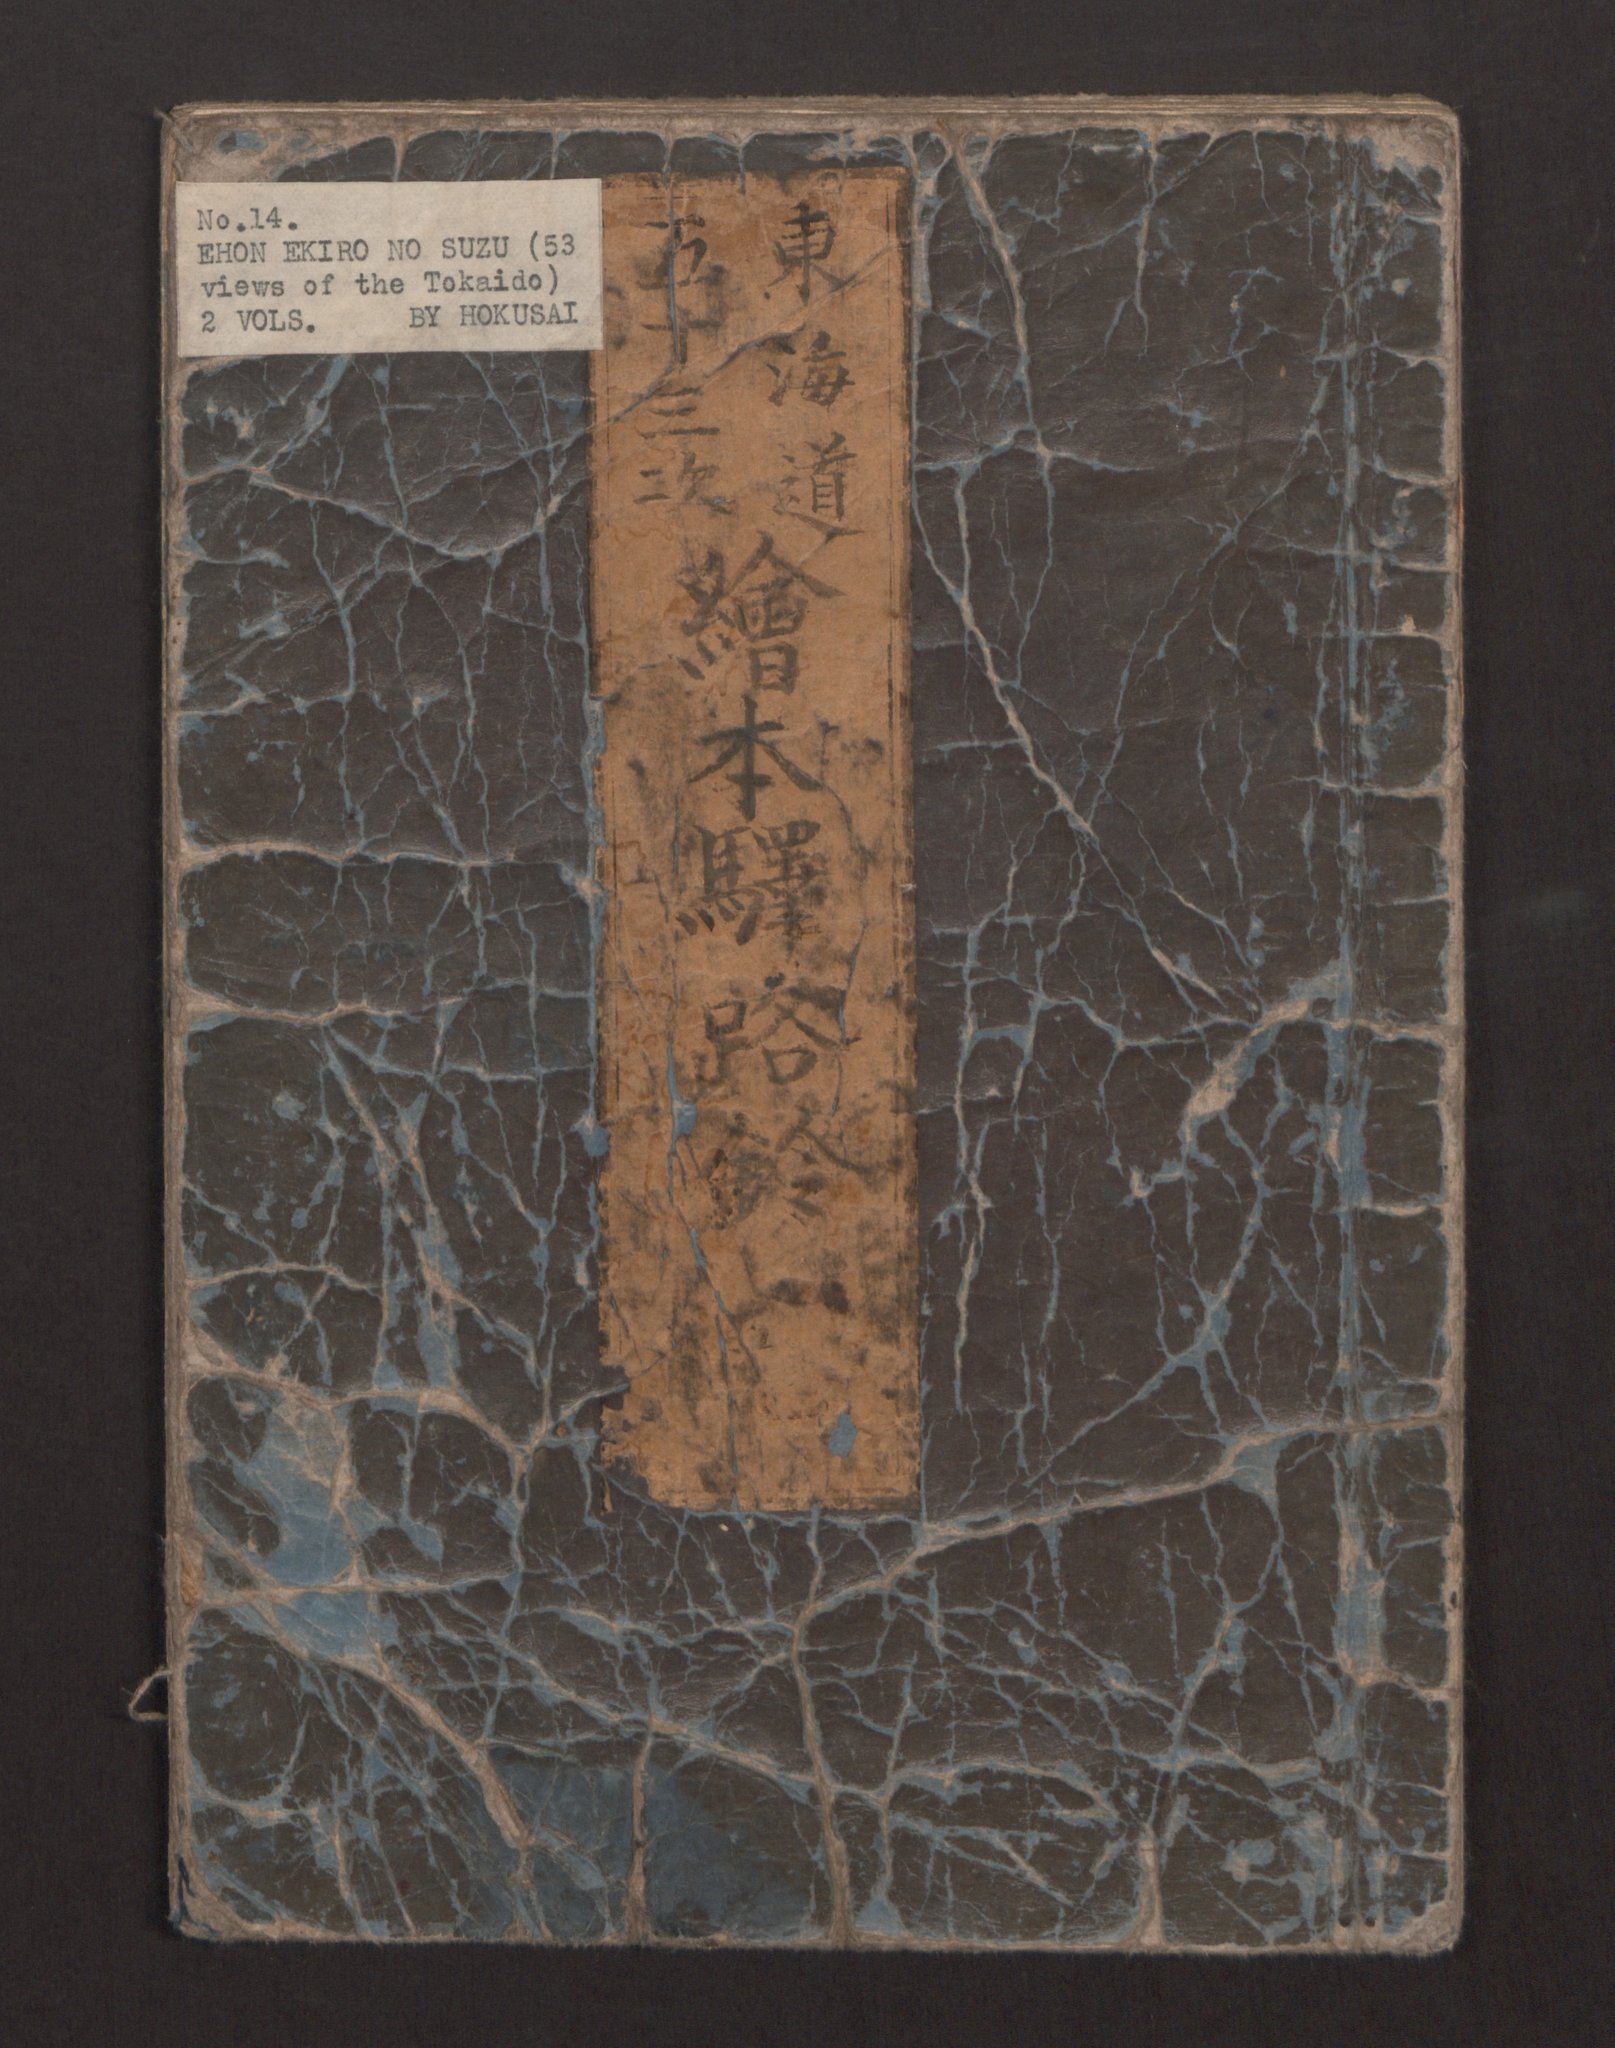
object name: illustrated book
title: Fifty-three Stations on the Tōkaidō Road (Tōkaidō gojūsantsugi ehon ekiro no suzu) 東海道五十三次絵本駅路鈴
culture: japanese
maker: katsushika hokusai 葛飾北斎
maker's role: artist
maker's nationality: japanese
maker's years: 1760-1849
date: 1840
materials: ink, paper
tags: houses,bridges,men,women